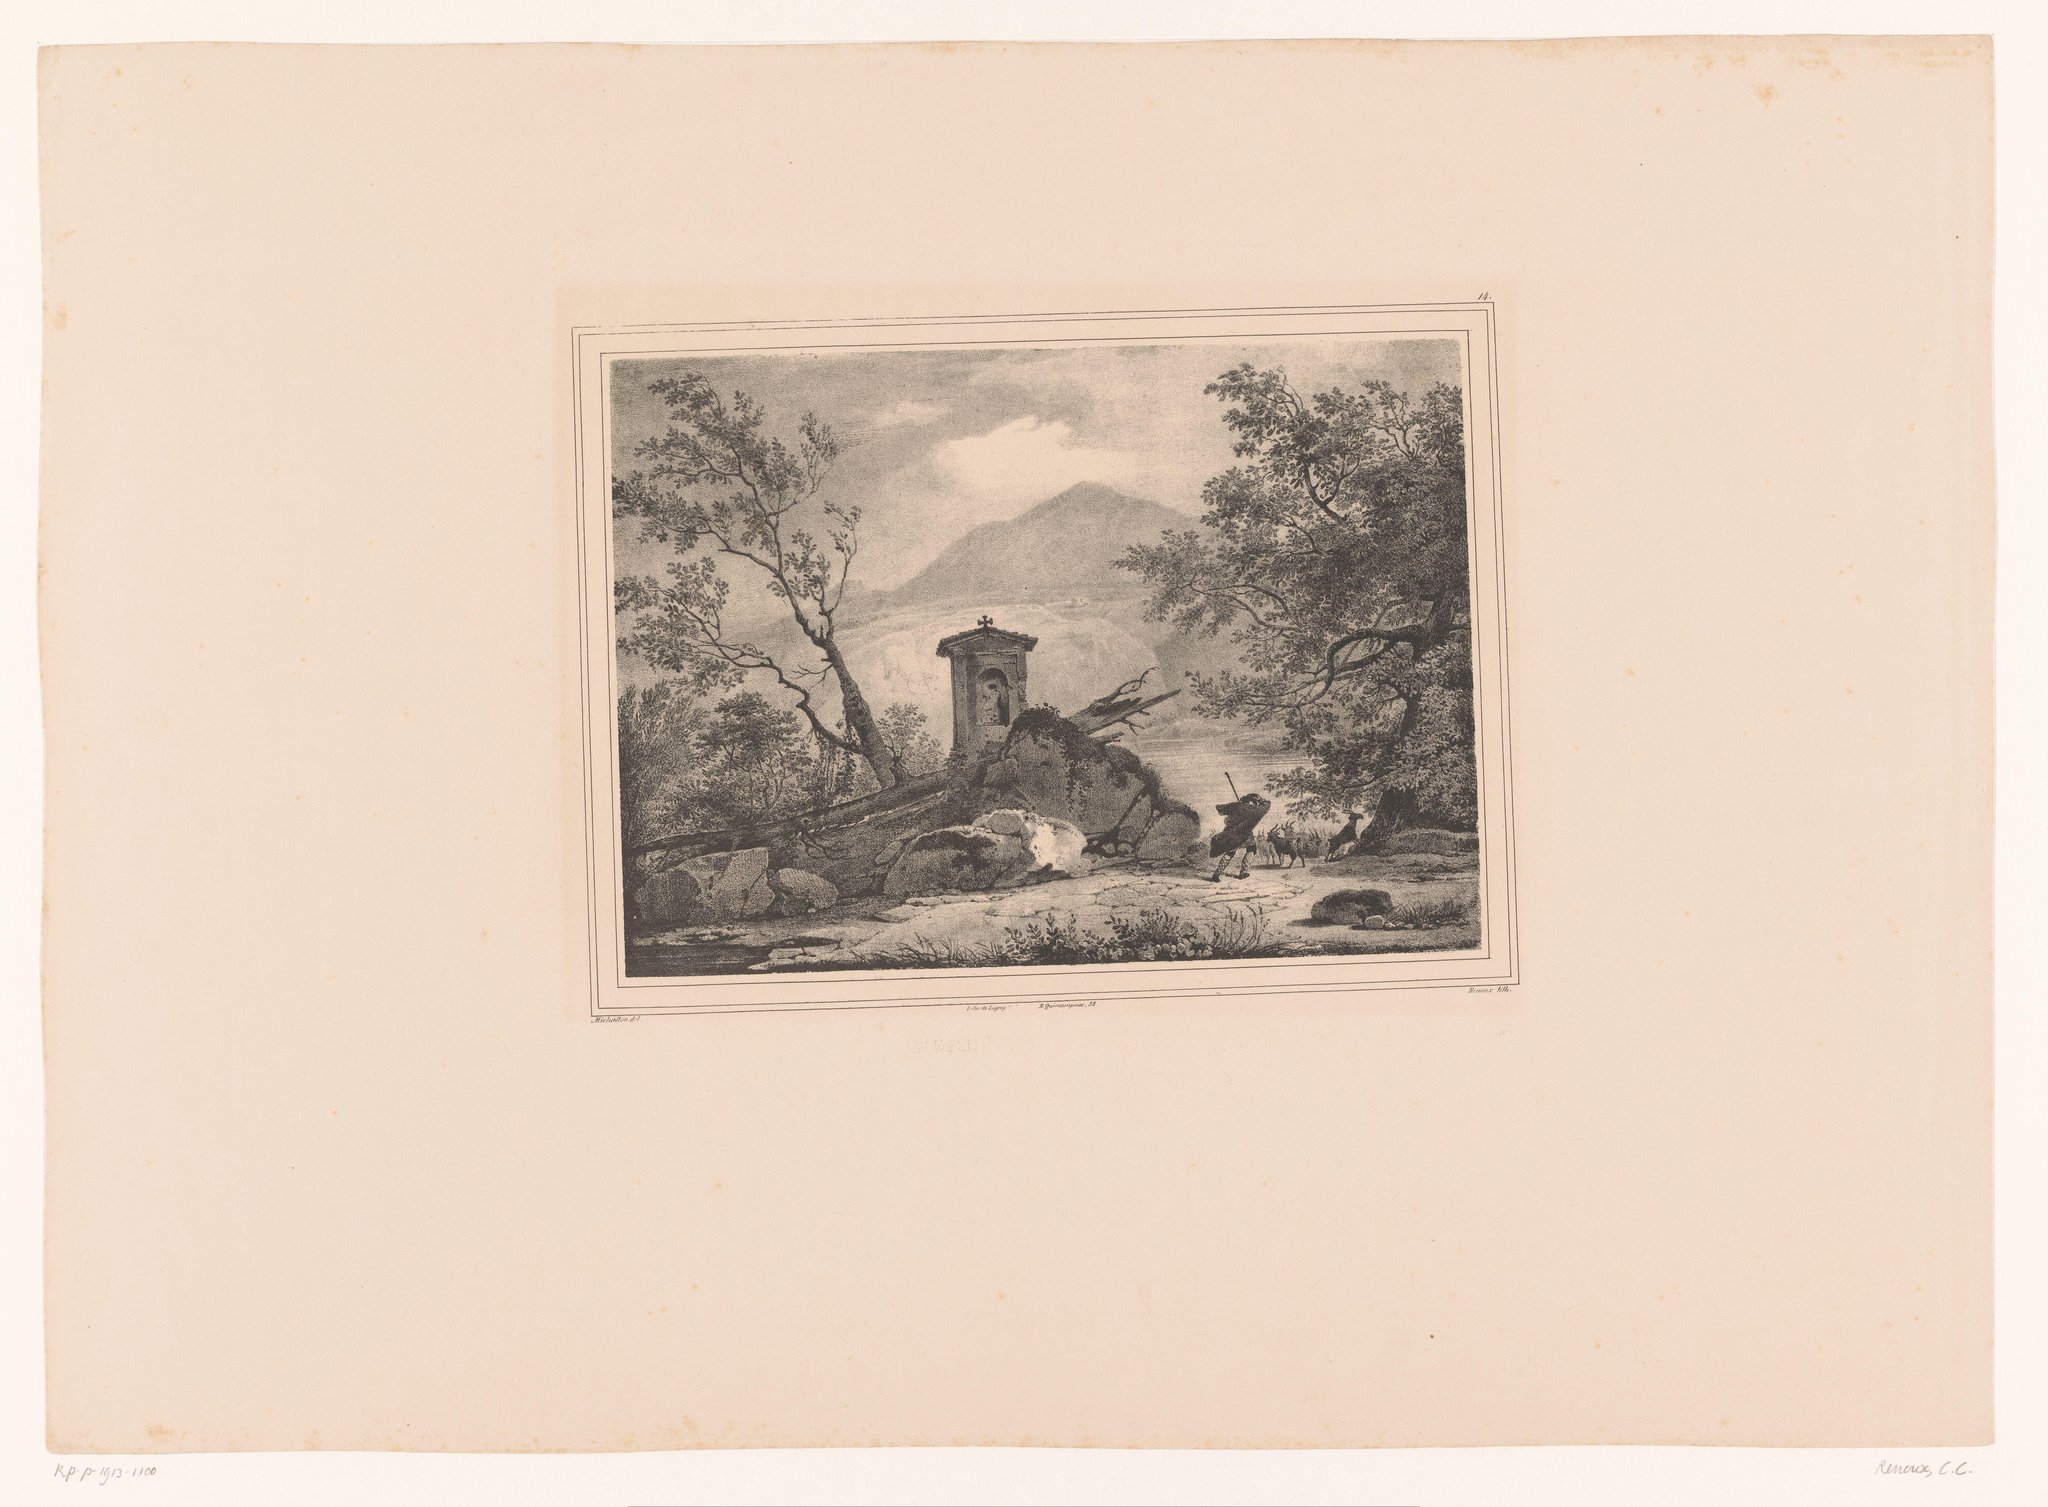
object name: print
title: Vues d'Italie et de Sicile, dessinées d'après nature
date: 1827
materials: paper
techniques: lithograph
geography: paris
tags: herding, herdsman, herdswoman, shepherd, shepherdess, cowherd, etc., lake (+ landscape with figures, staffage)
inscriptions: collector's mark: Lugt 2228a